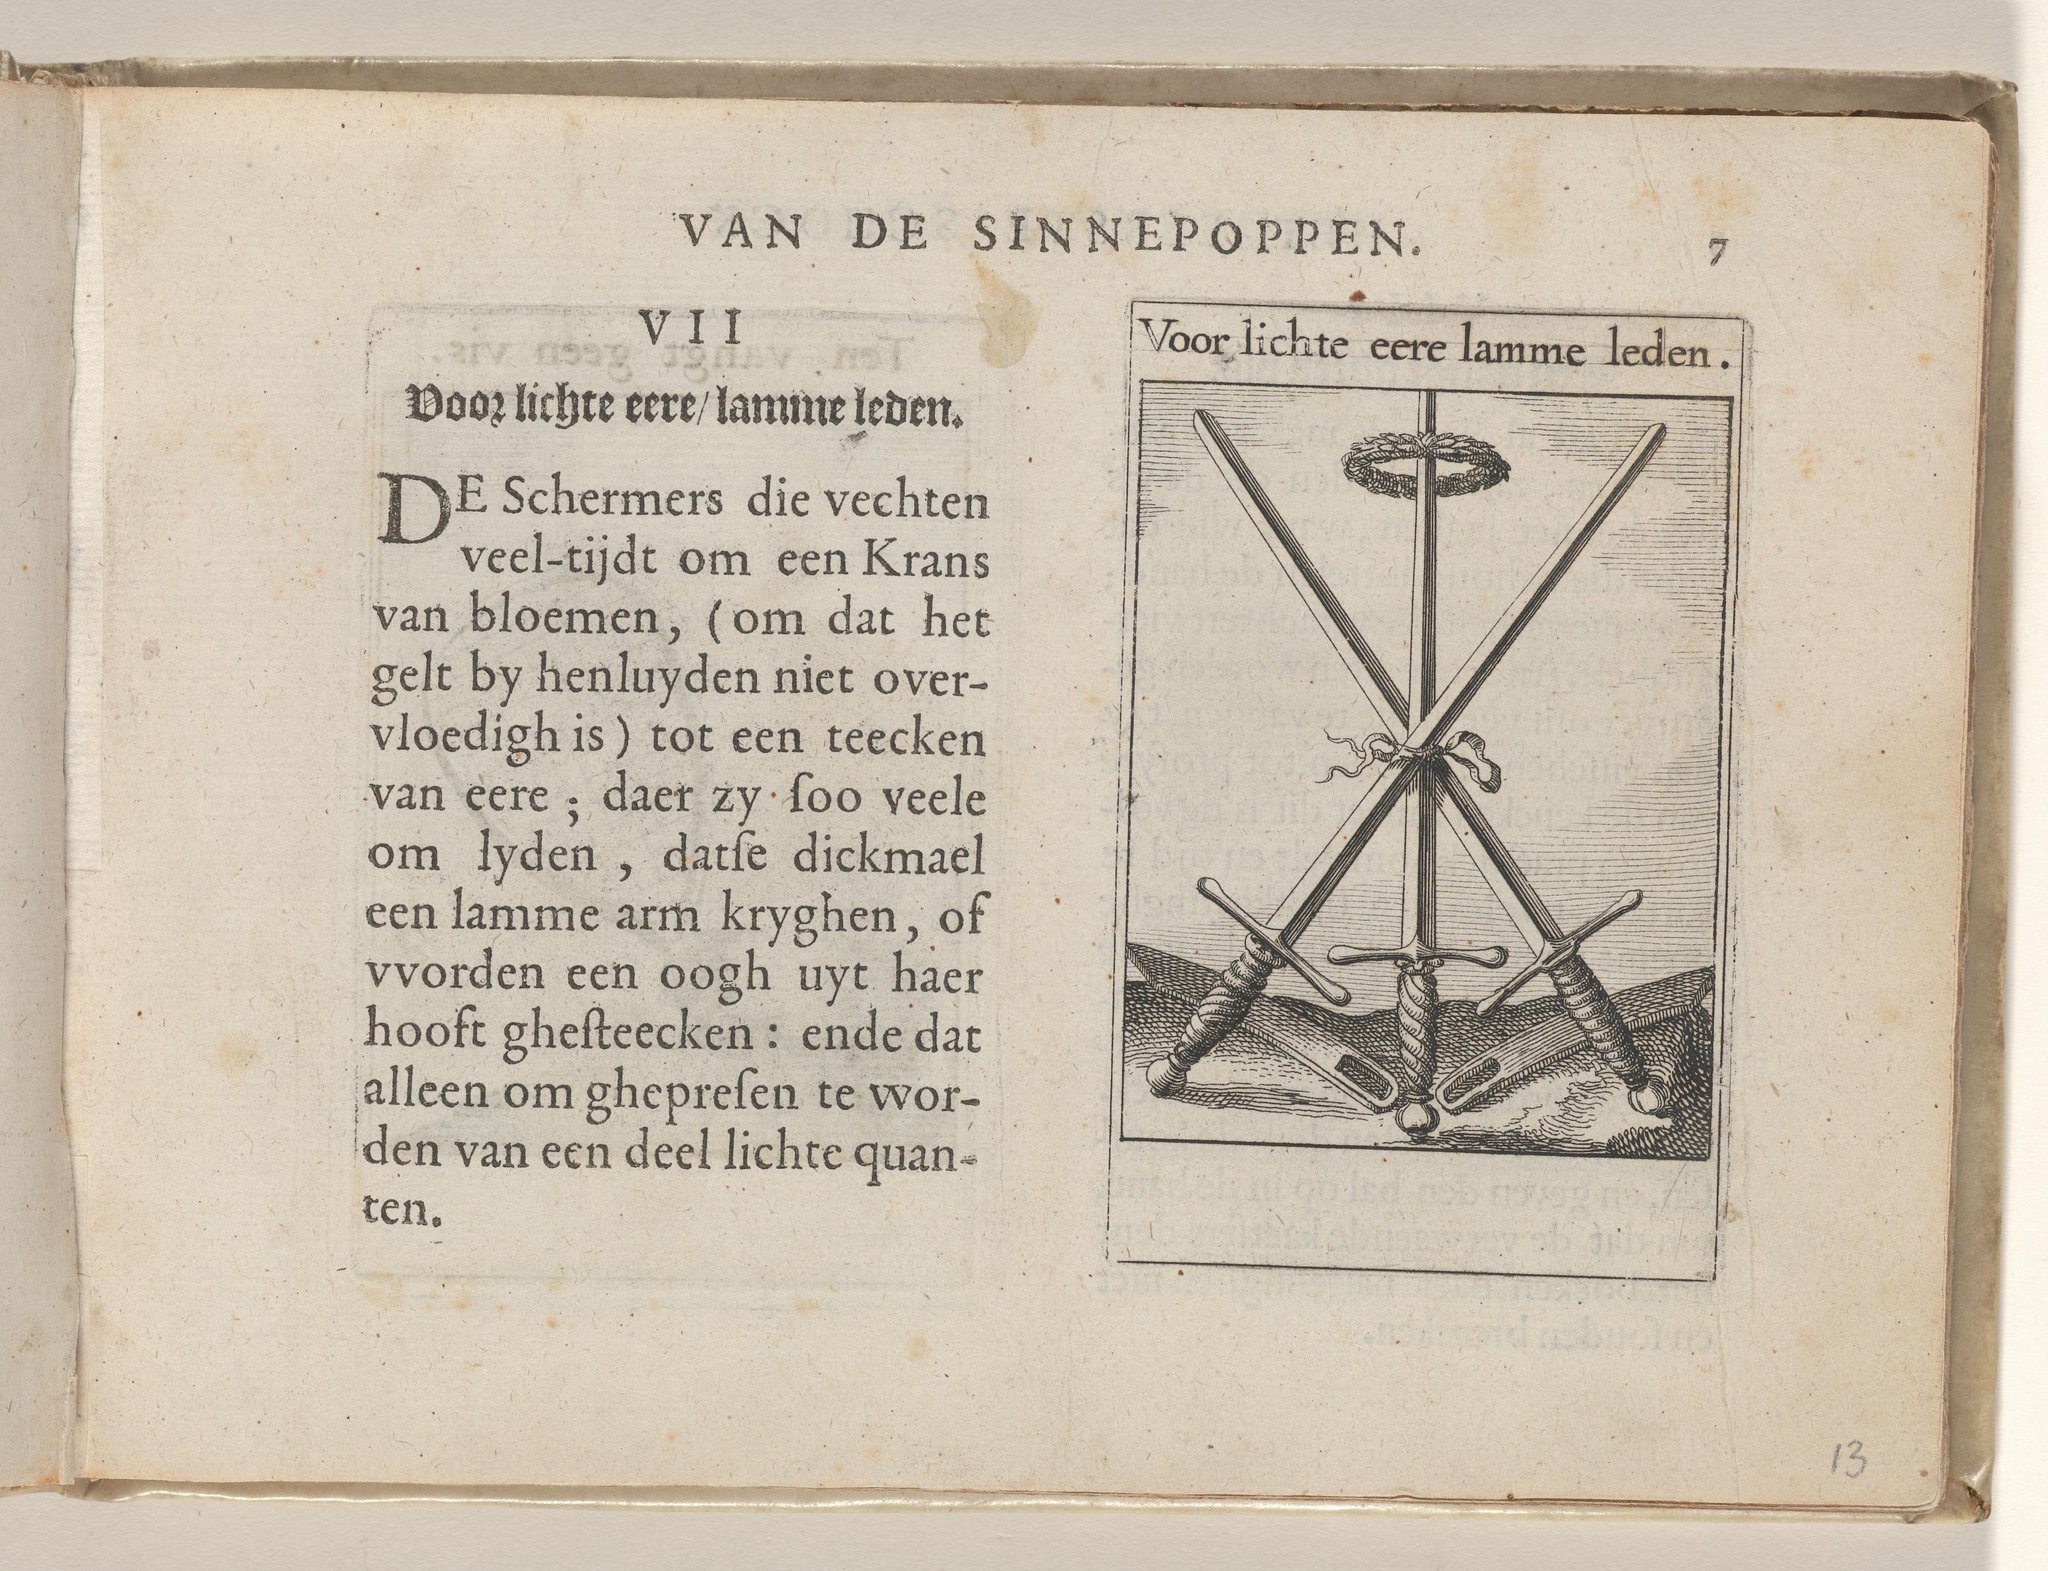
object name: album leaf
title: VII Voor lichte eere lamme leden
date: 1614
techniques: engraving, printing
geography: the hague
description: VII Voor lichte eere lamme leden. Eerste schok. Onderdeel van 'Sinnepoppen', R. Visscher, 1614.